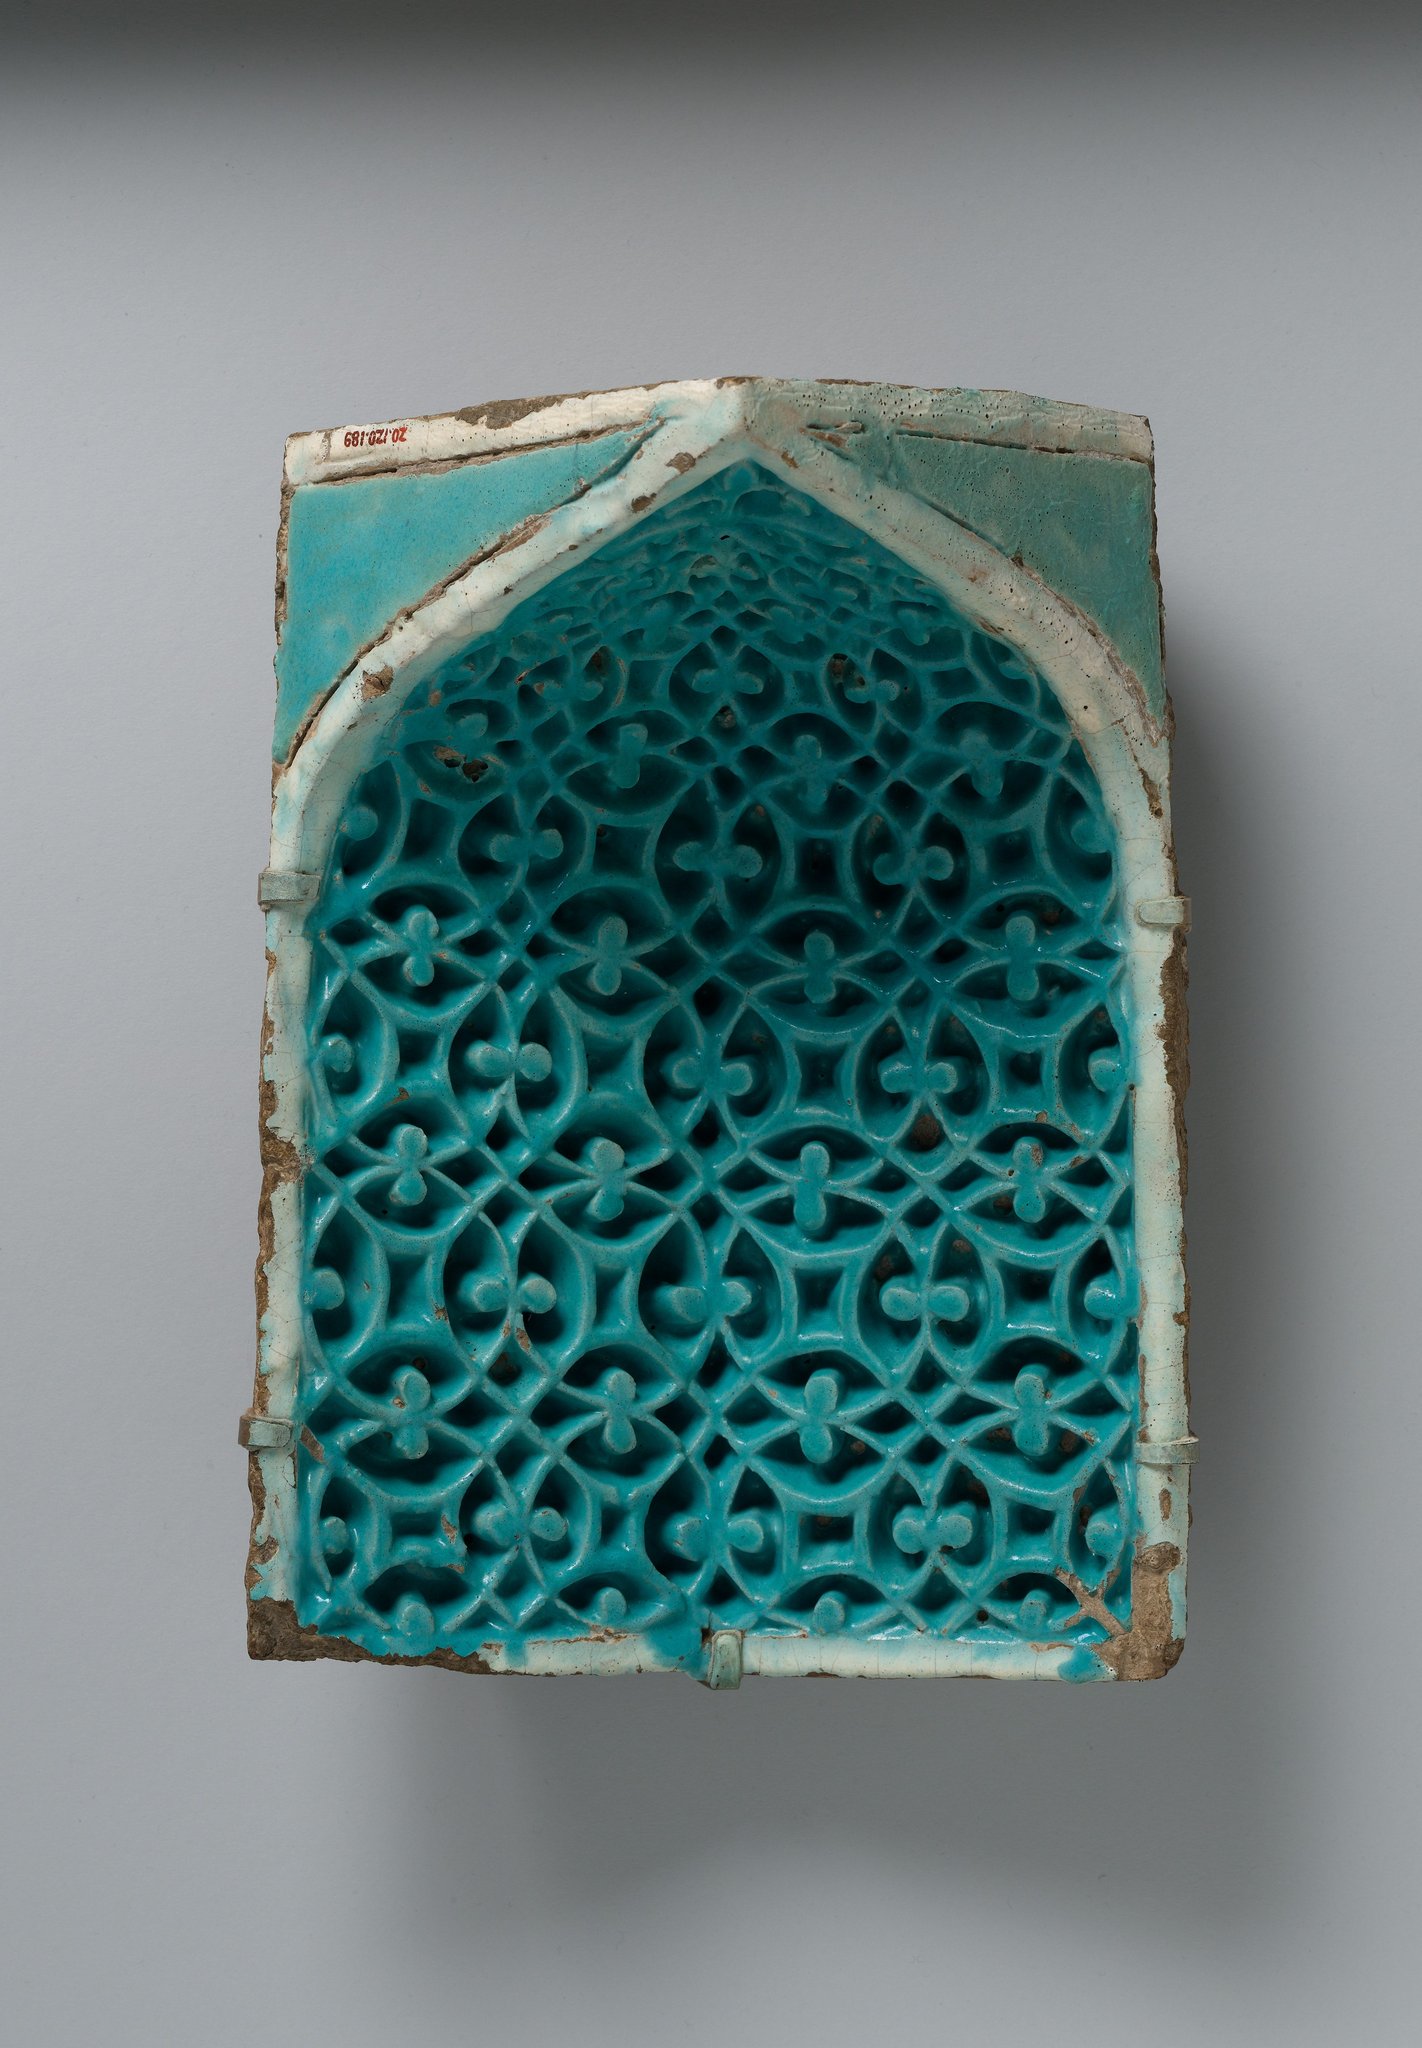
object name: tile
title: Tile from a Squinch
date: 1351-1400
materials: stonepaste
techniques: carving, glazing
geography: uzbekistan